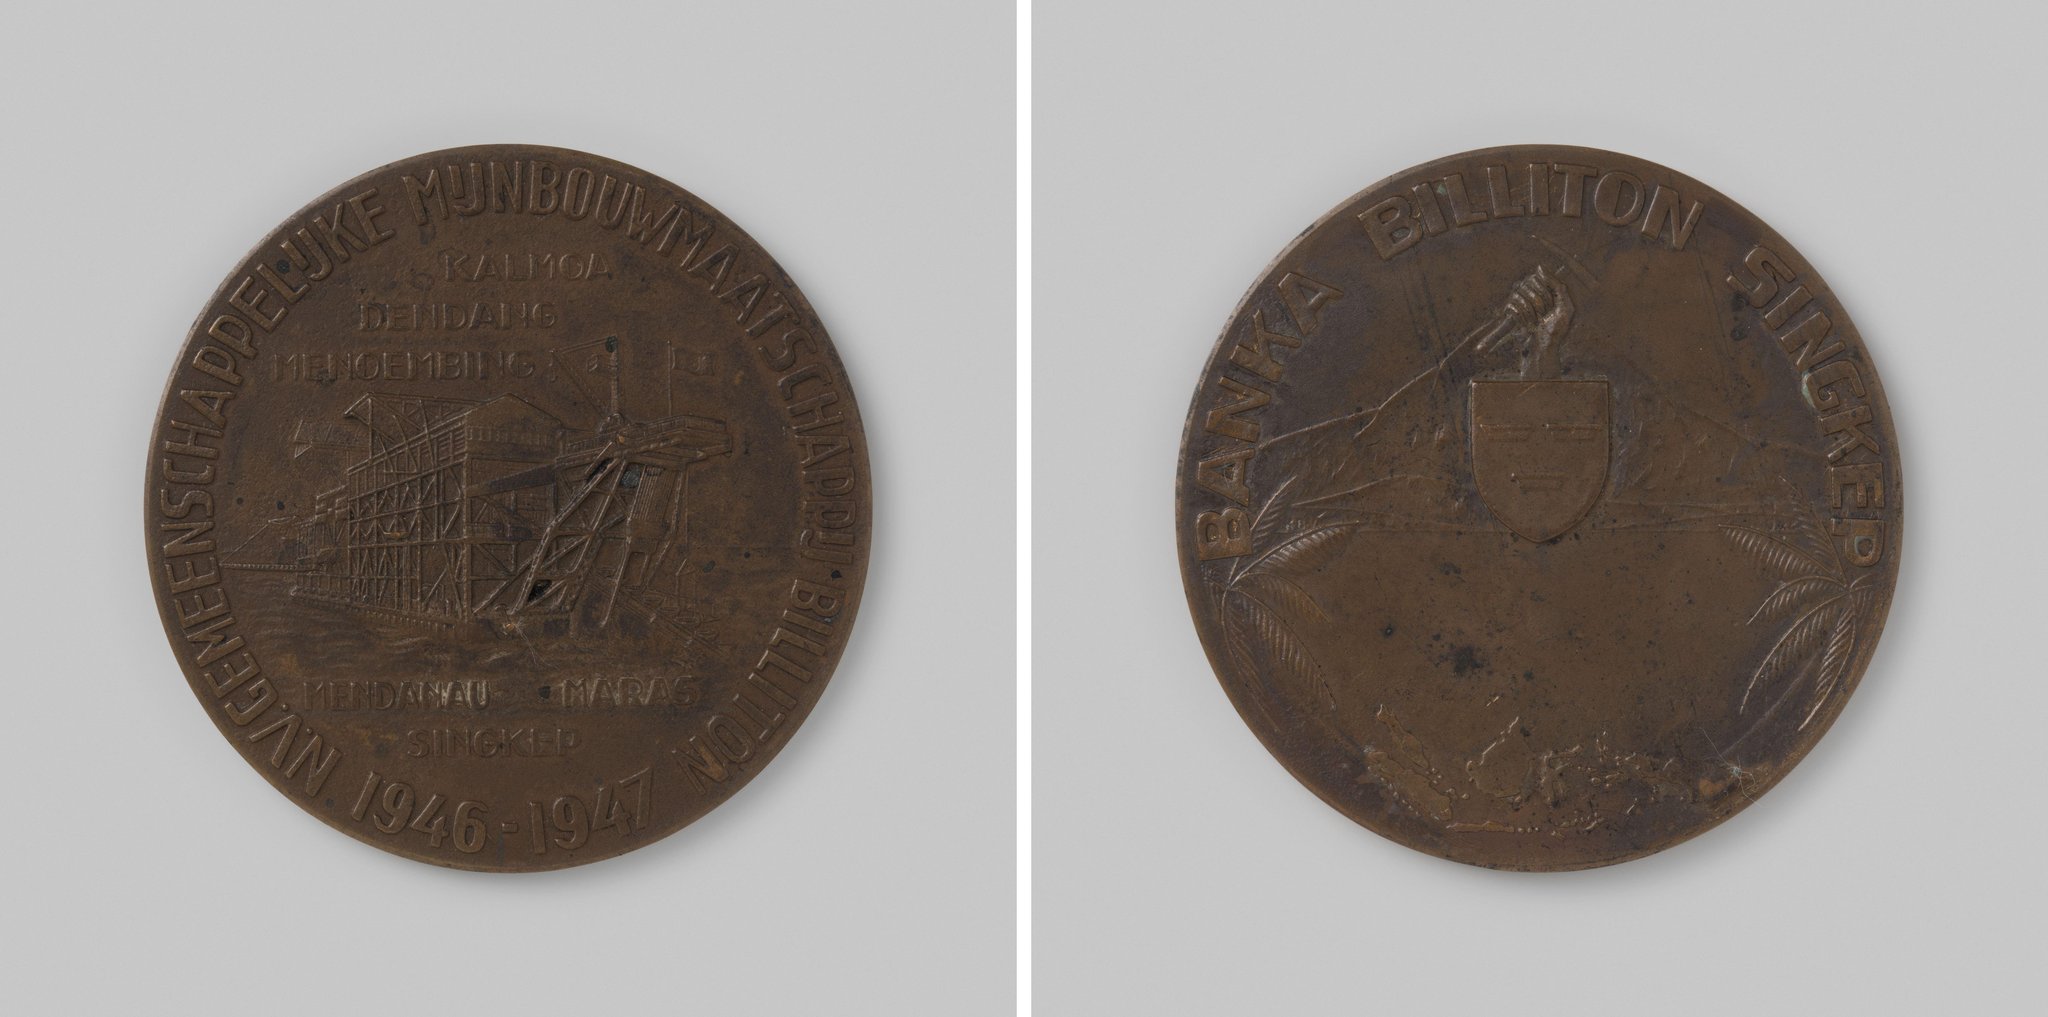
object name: medal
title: NV Gemeenschappelijke Mijnbouwmaatschappij Billiton 1946-1947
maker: j.ph. van zegveld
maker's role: medailleur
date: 1947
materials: bronze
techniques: striking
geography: voorschoten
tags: indonesia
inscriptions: circumscription: ‘Banka Billiton Singkep’, circumscription: ‘NV Gemeenschappelijke Mijnbouwmaatschappij Billiton 1946-1947’, inscription: ‘Kalmoa // Dendang // Menoembing’, coat of arms, inscription: ‘Mendanau Maras // Sinkep’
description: Bronzen penning. Voorzijde: tinbaggermolen in perspectief met opschriften binnen omschrift. Keerzijde: wapenschild met drie tinnen broodjes en als helmteken een hand die een hamer vasthoudt, voor berglandschap, met onder een kaart van Indonesië met ter weerszijden twee palmbomen met aan bovenzijde randschrift.